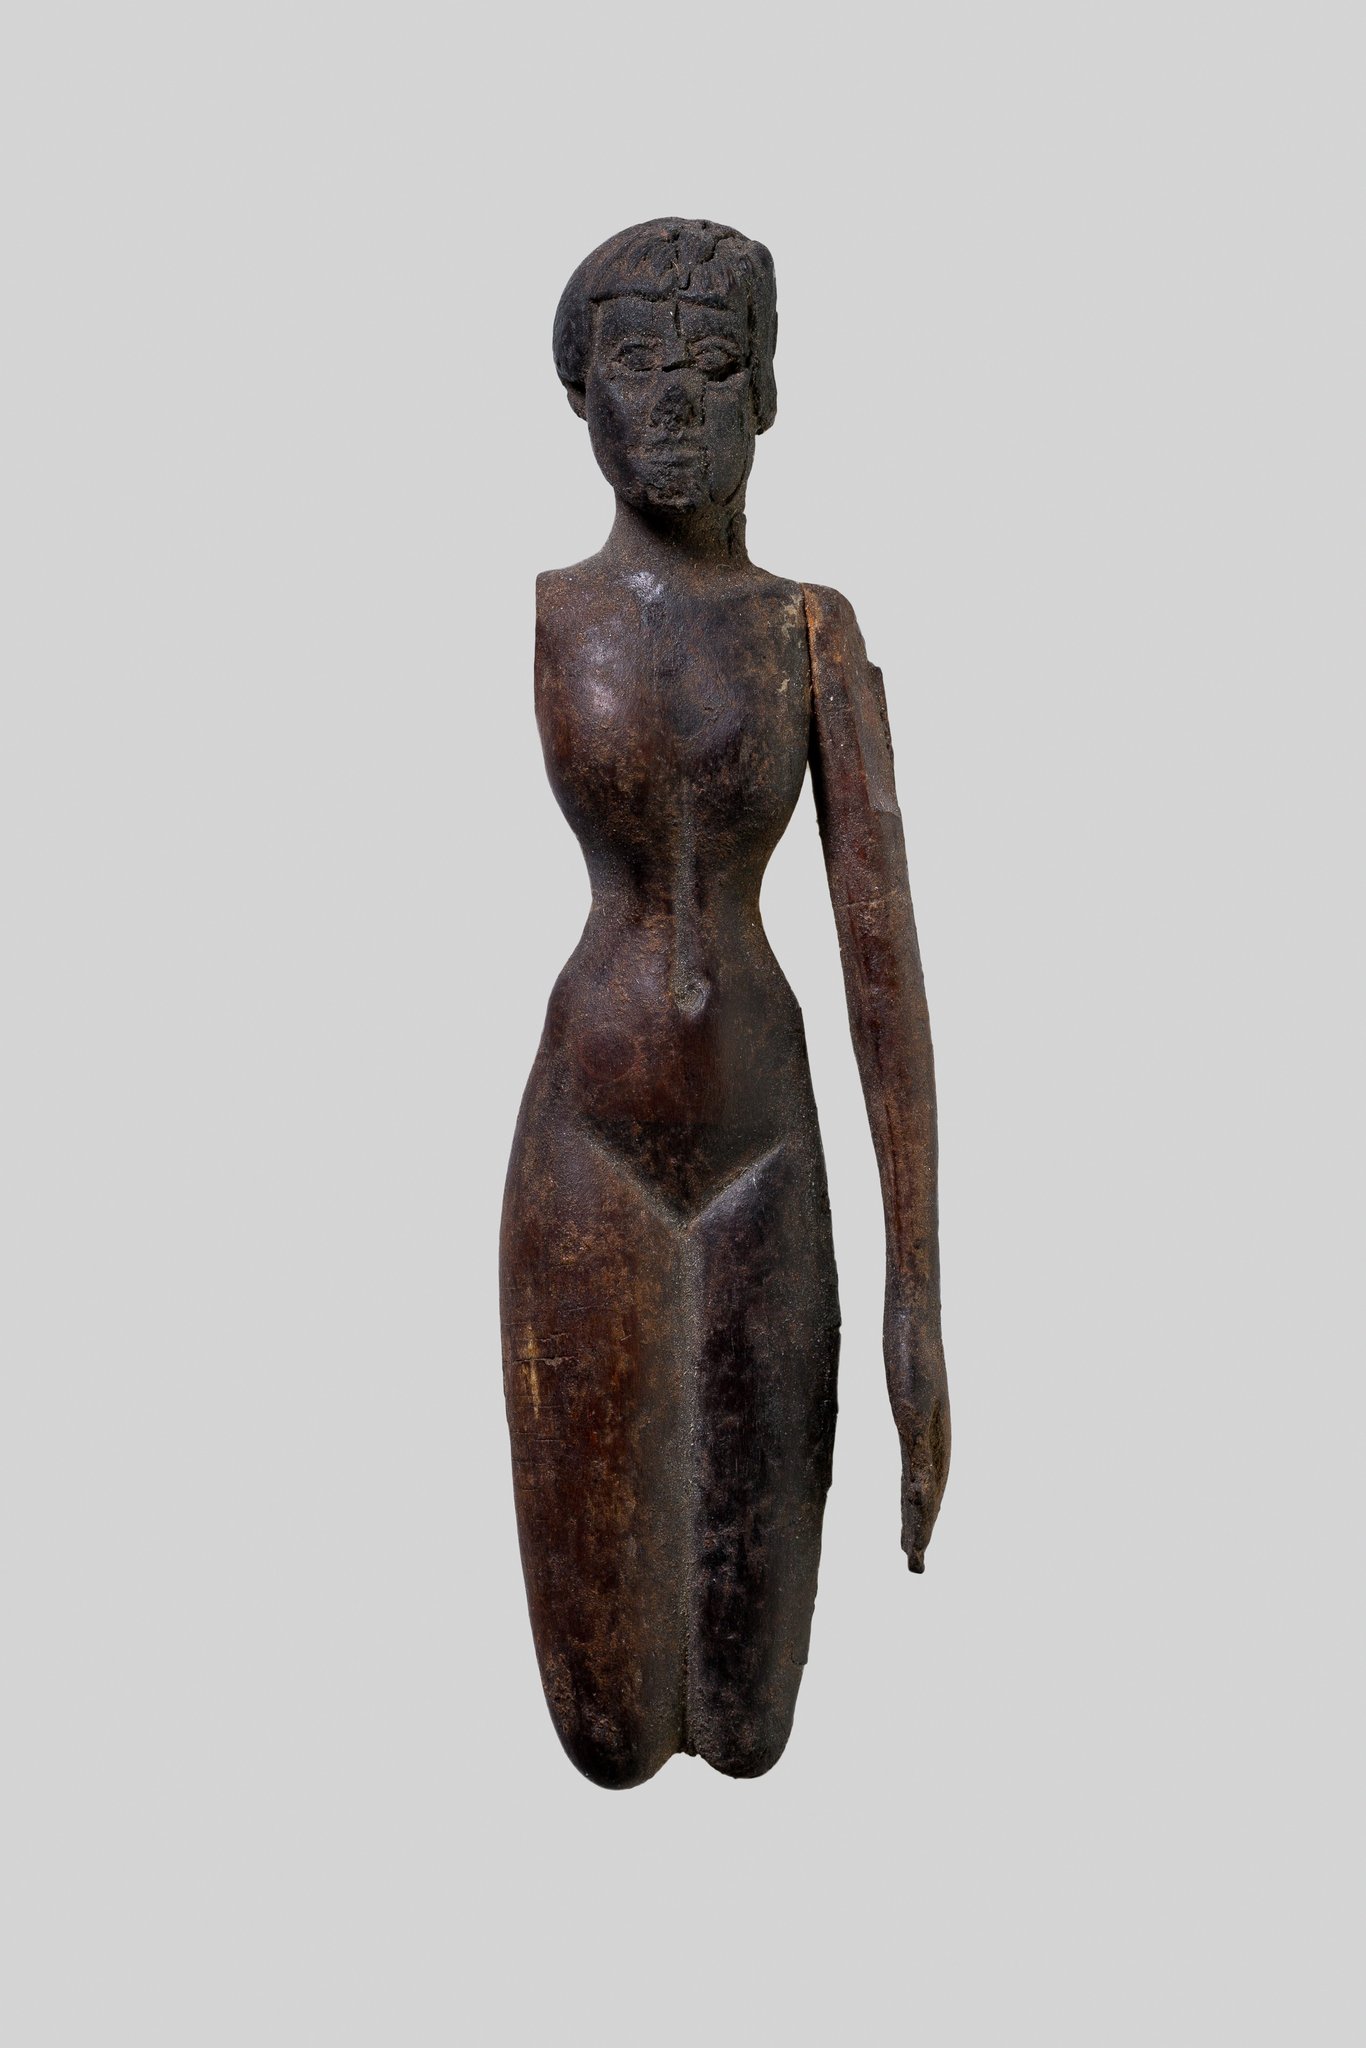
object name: statuette of neferhotep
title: Female figurine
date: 2030-1640 BCE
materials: wood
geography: egypt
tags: women